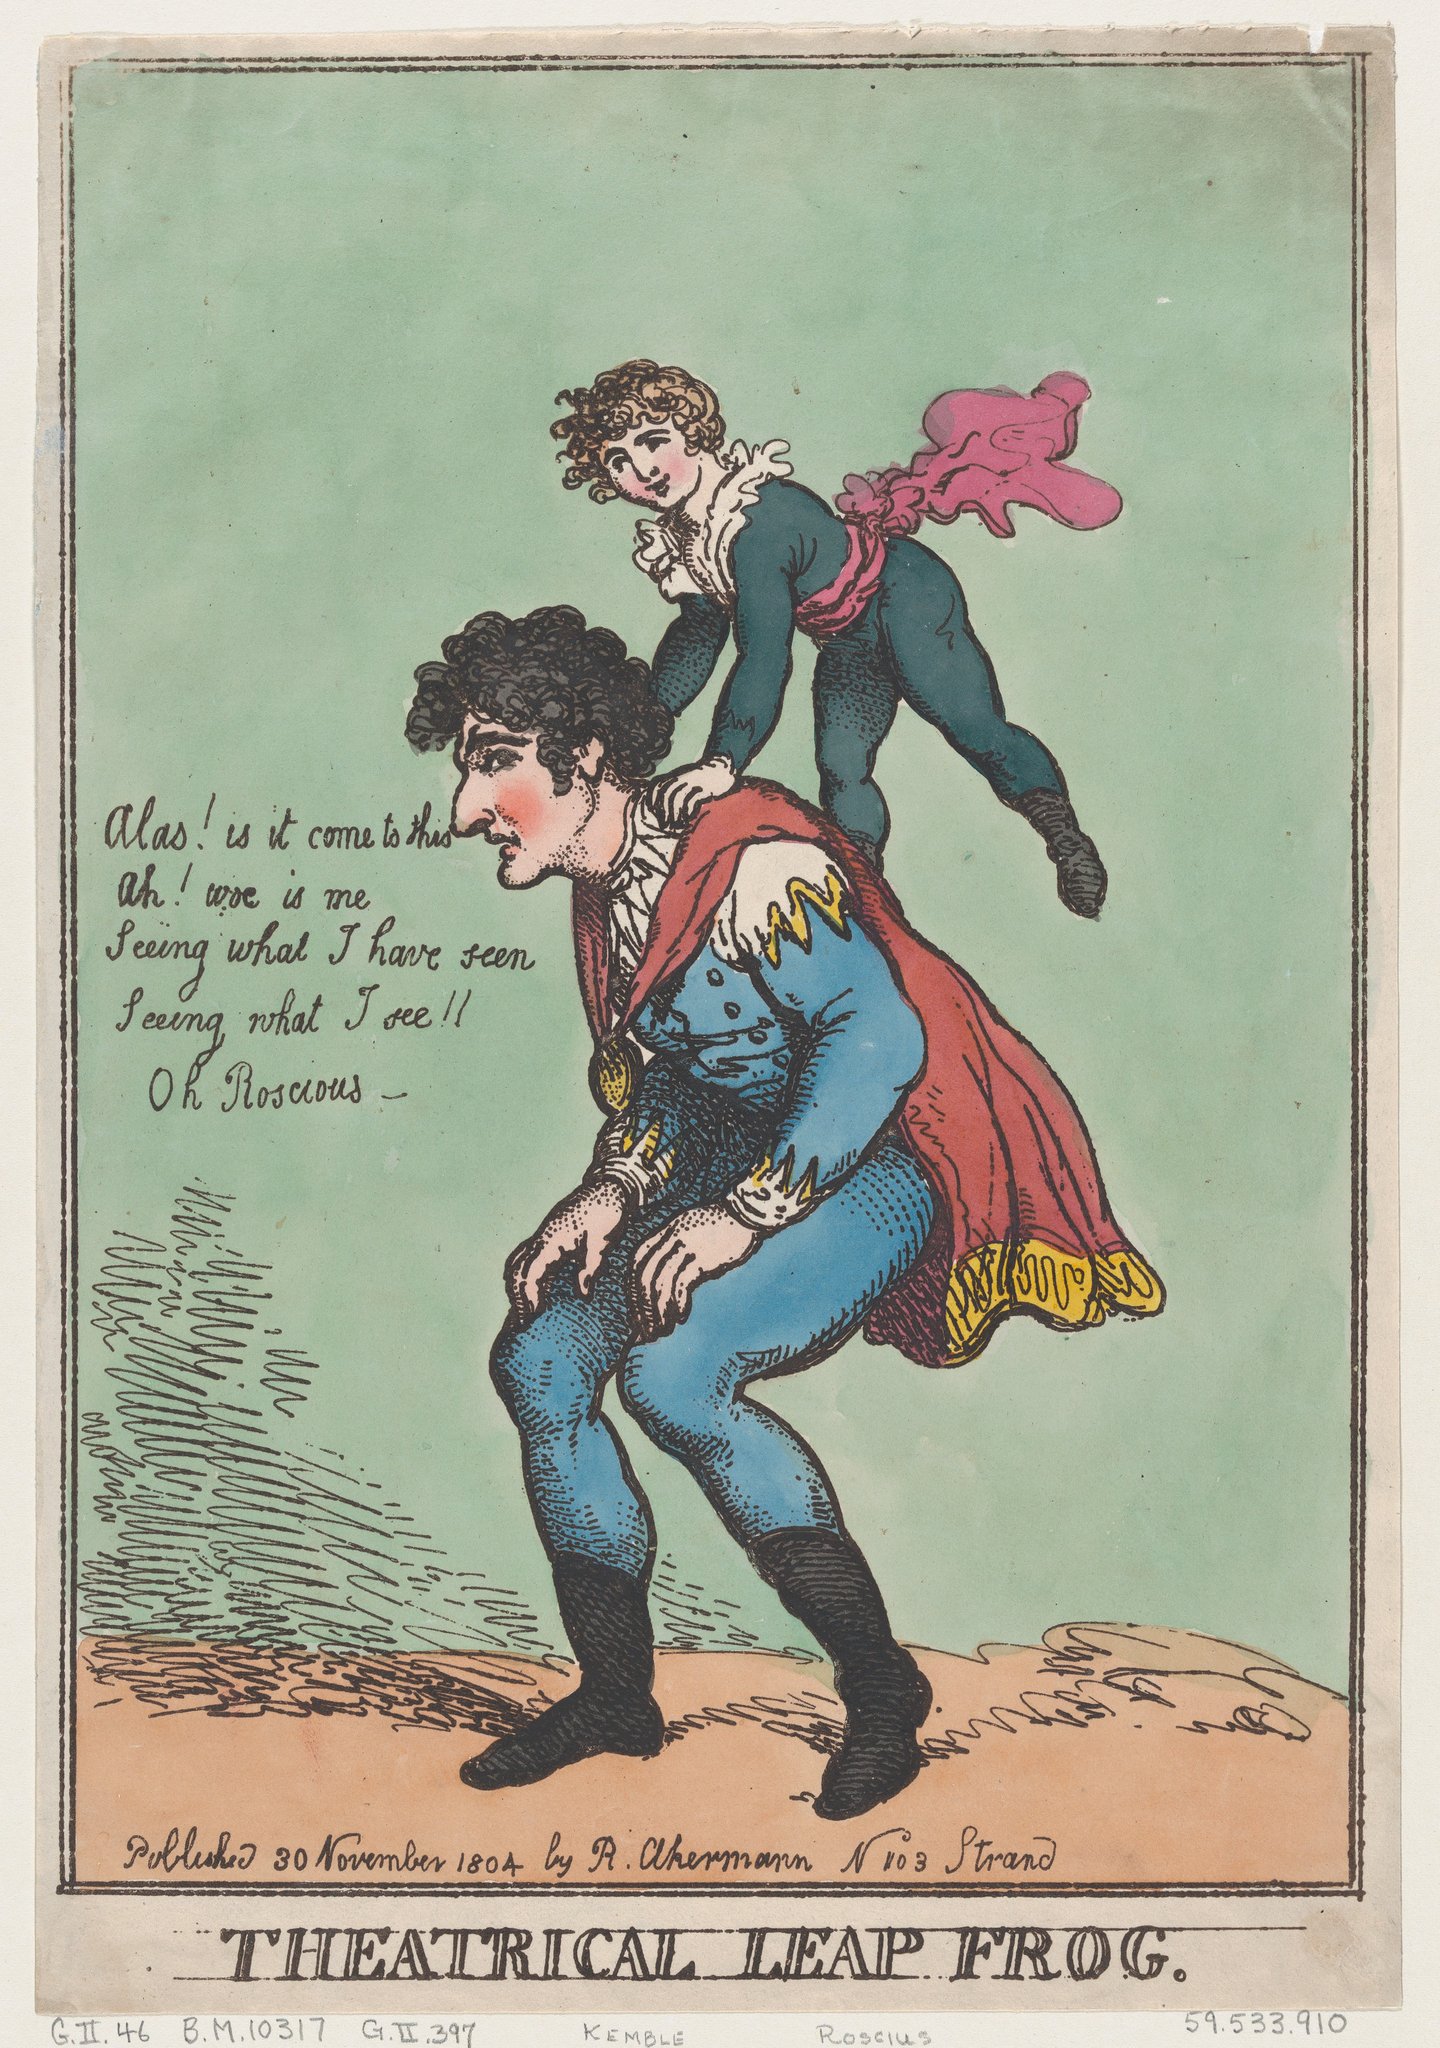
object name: print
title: Theatrical Leap Frog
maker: thomas rowlandson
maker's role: artist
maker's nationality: british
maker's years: 1757-1827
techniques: etching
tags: satire,children,men